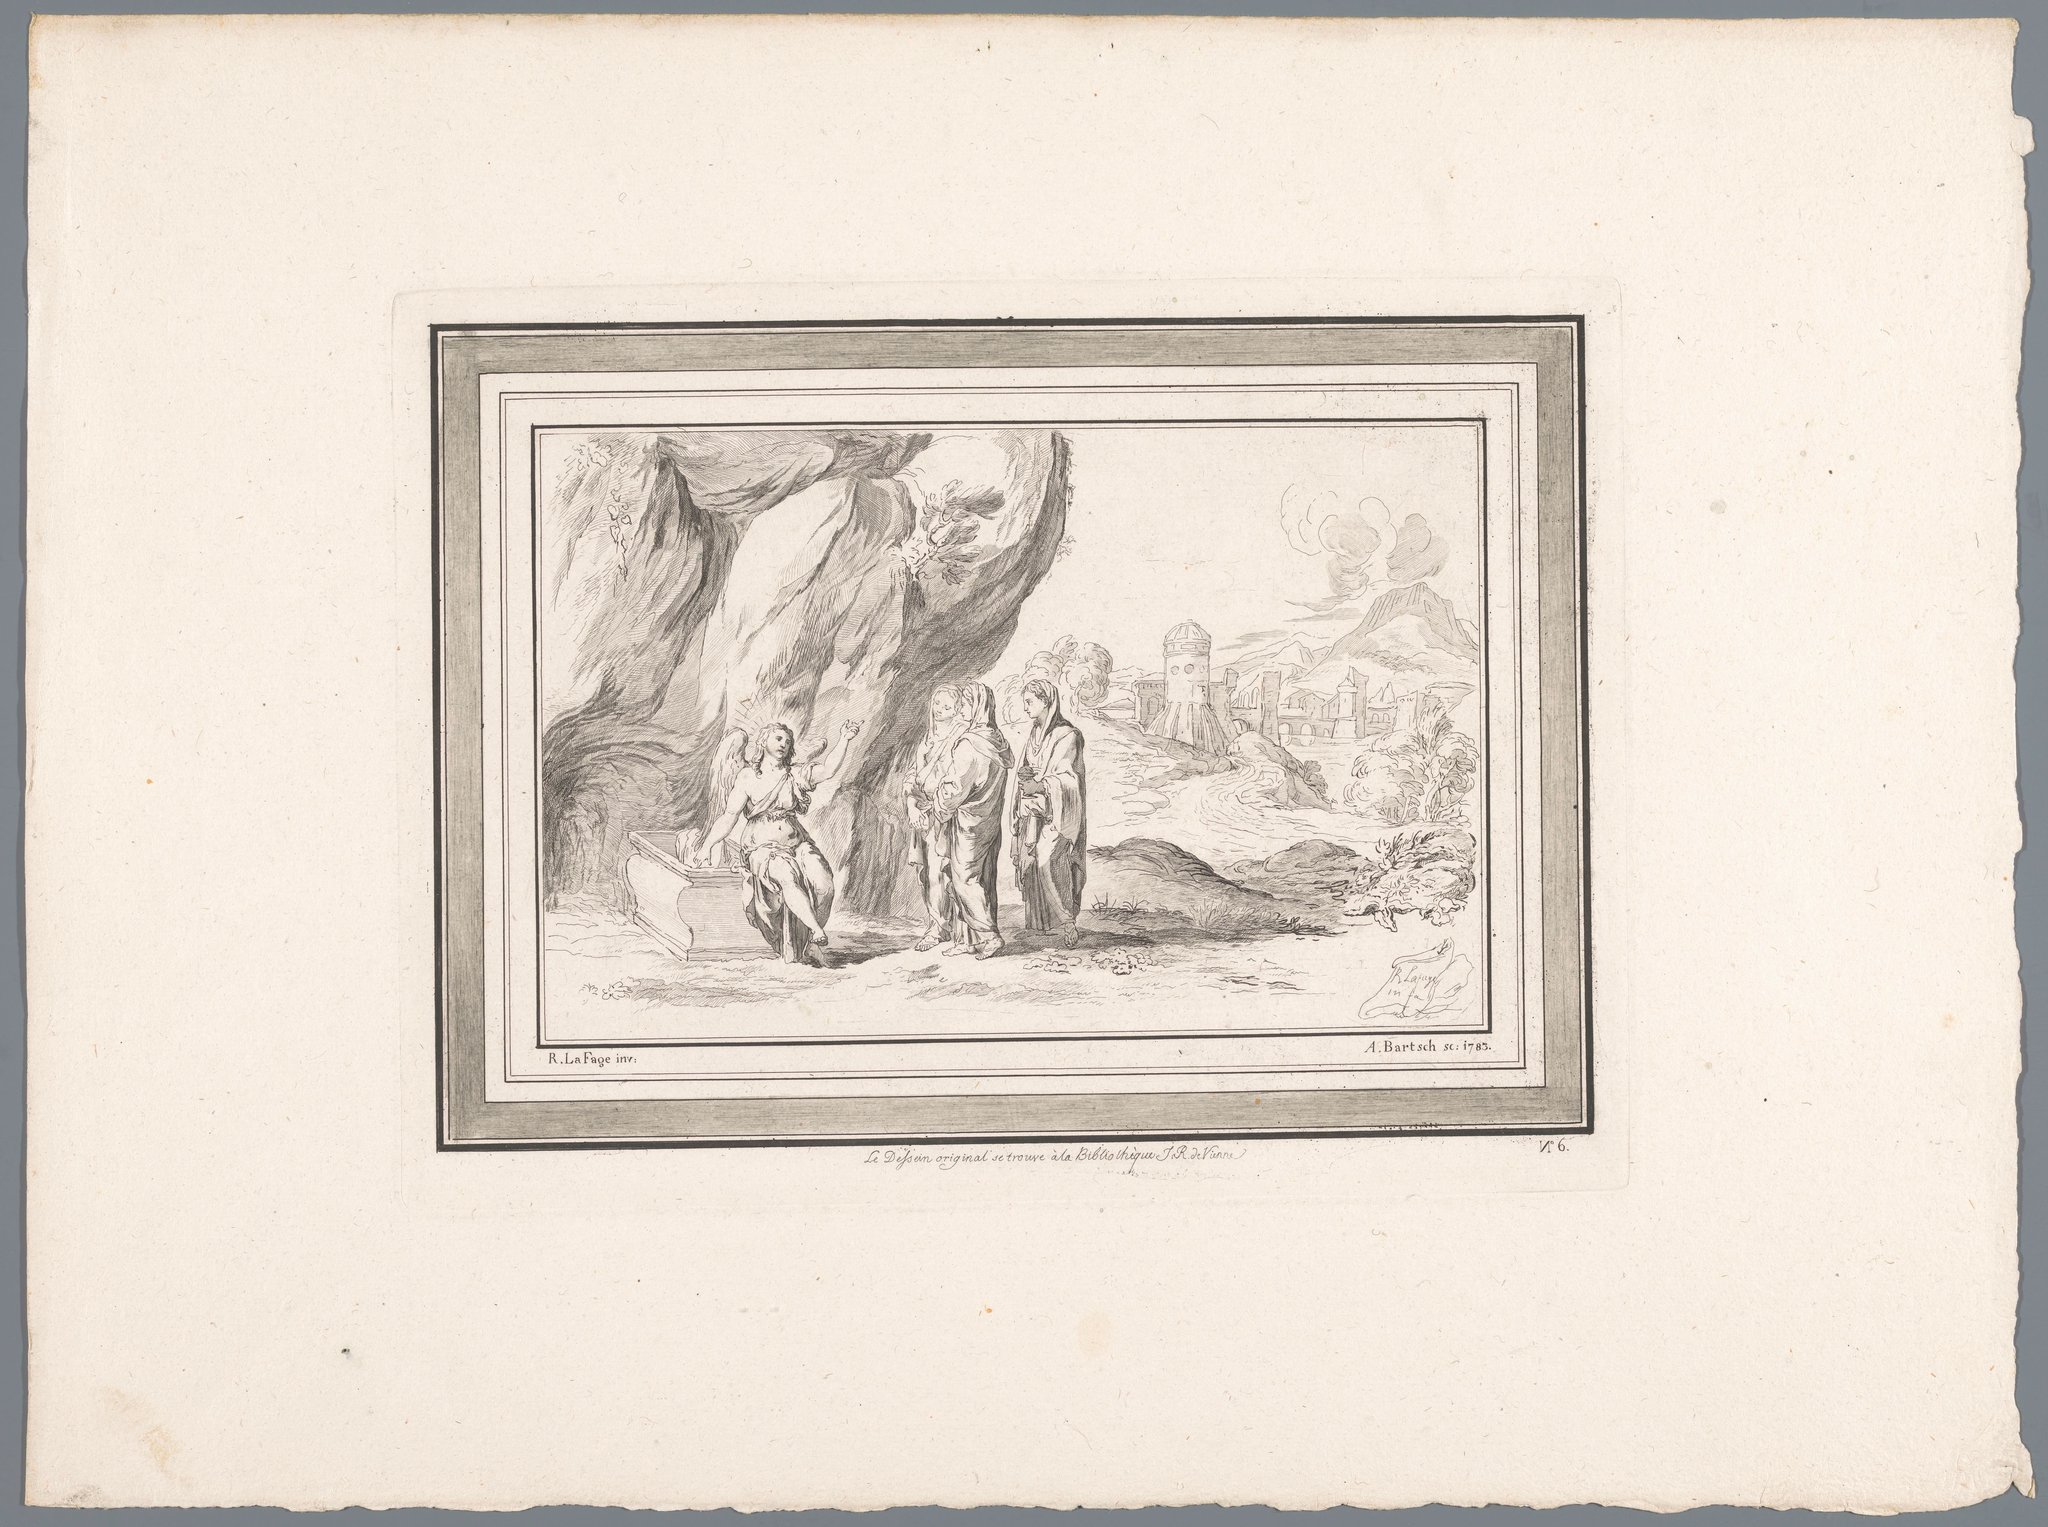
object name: print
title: Drie Maria's bij het graf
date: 1783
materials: paper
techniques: engraving, etching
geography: france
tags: the holy women (the three maries) on their way to or at the tomb, to anoint christ's body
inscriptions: collector's mark: Lugt 2228